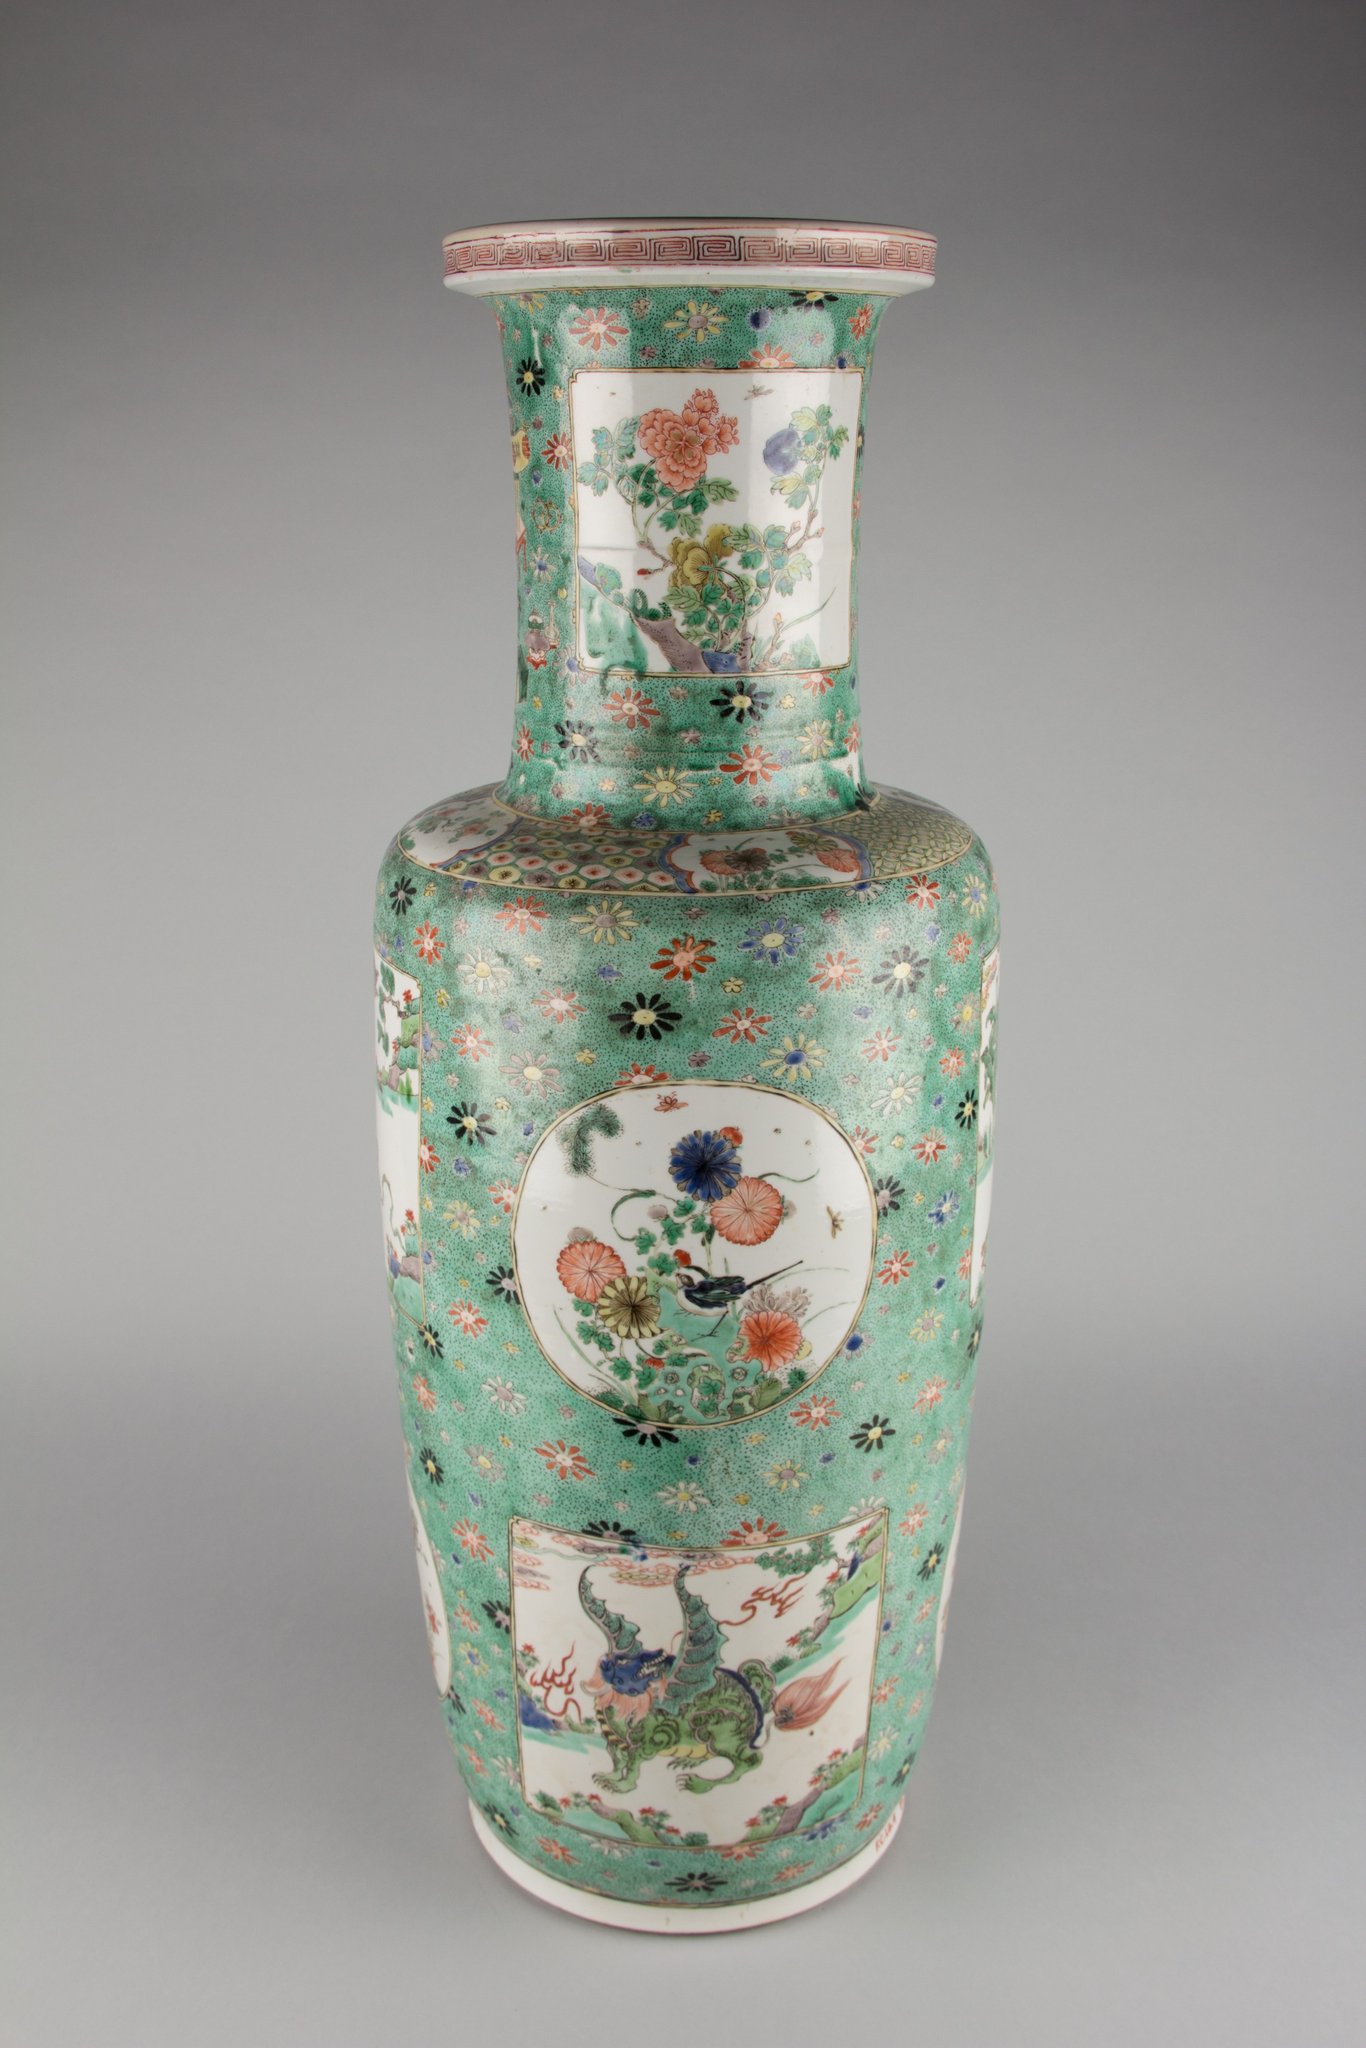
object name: vase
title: Vase with auspicious animals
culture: chinese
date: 1662-1722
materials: enamel, porcelain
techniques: overglaze, painting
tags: animals,birds